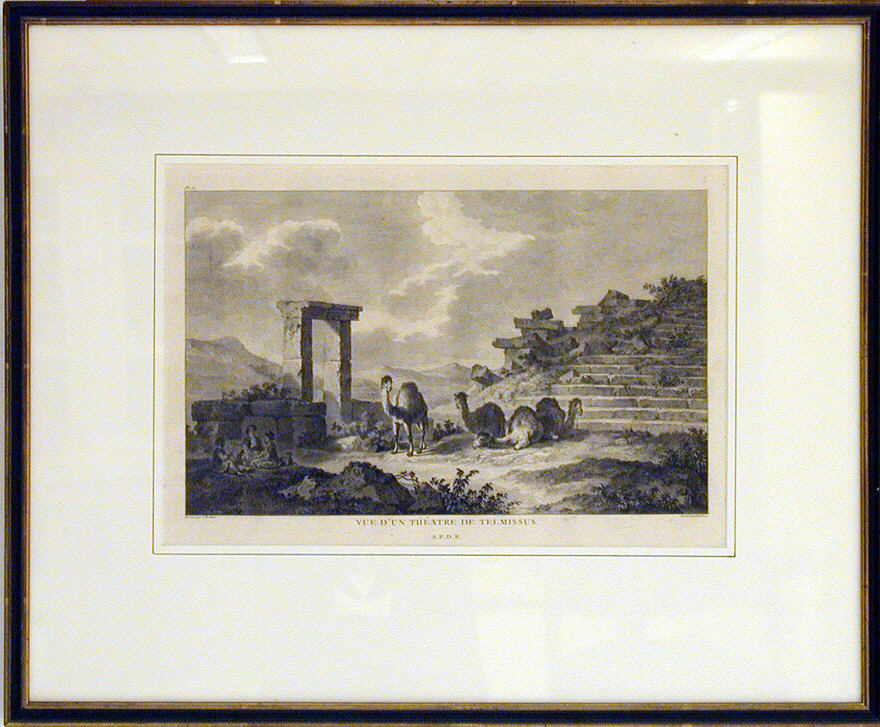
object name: engraving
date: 1701-1800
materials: ink, paper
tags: ruins,maps